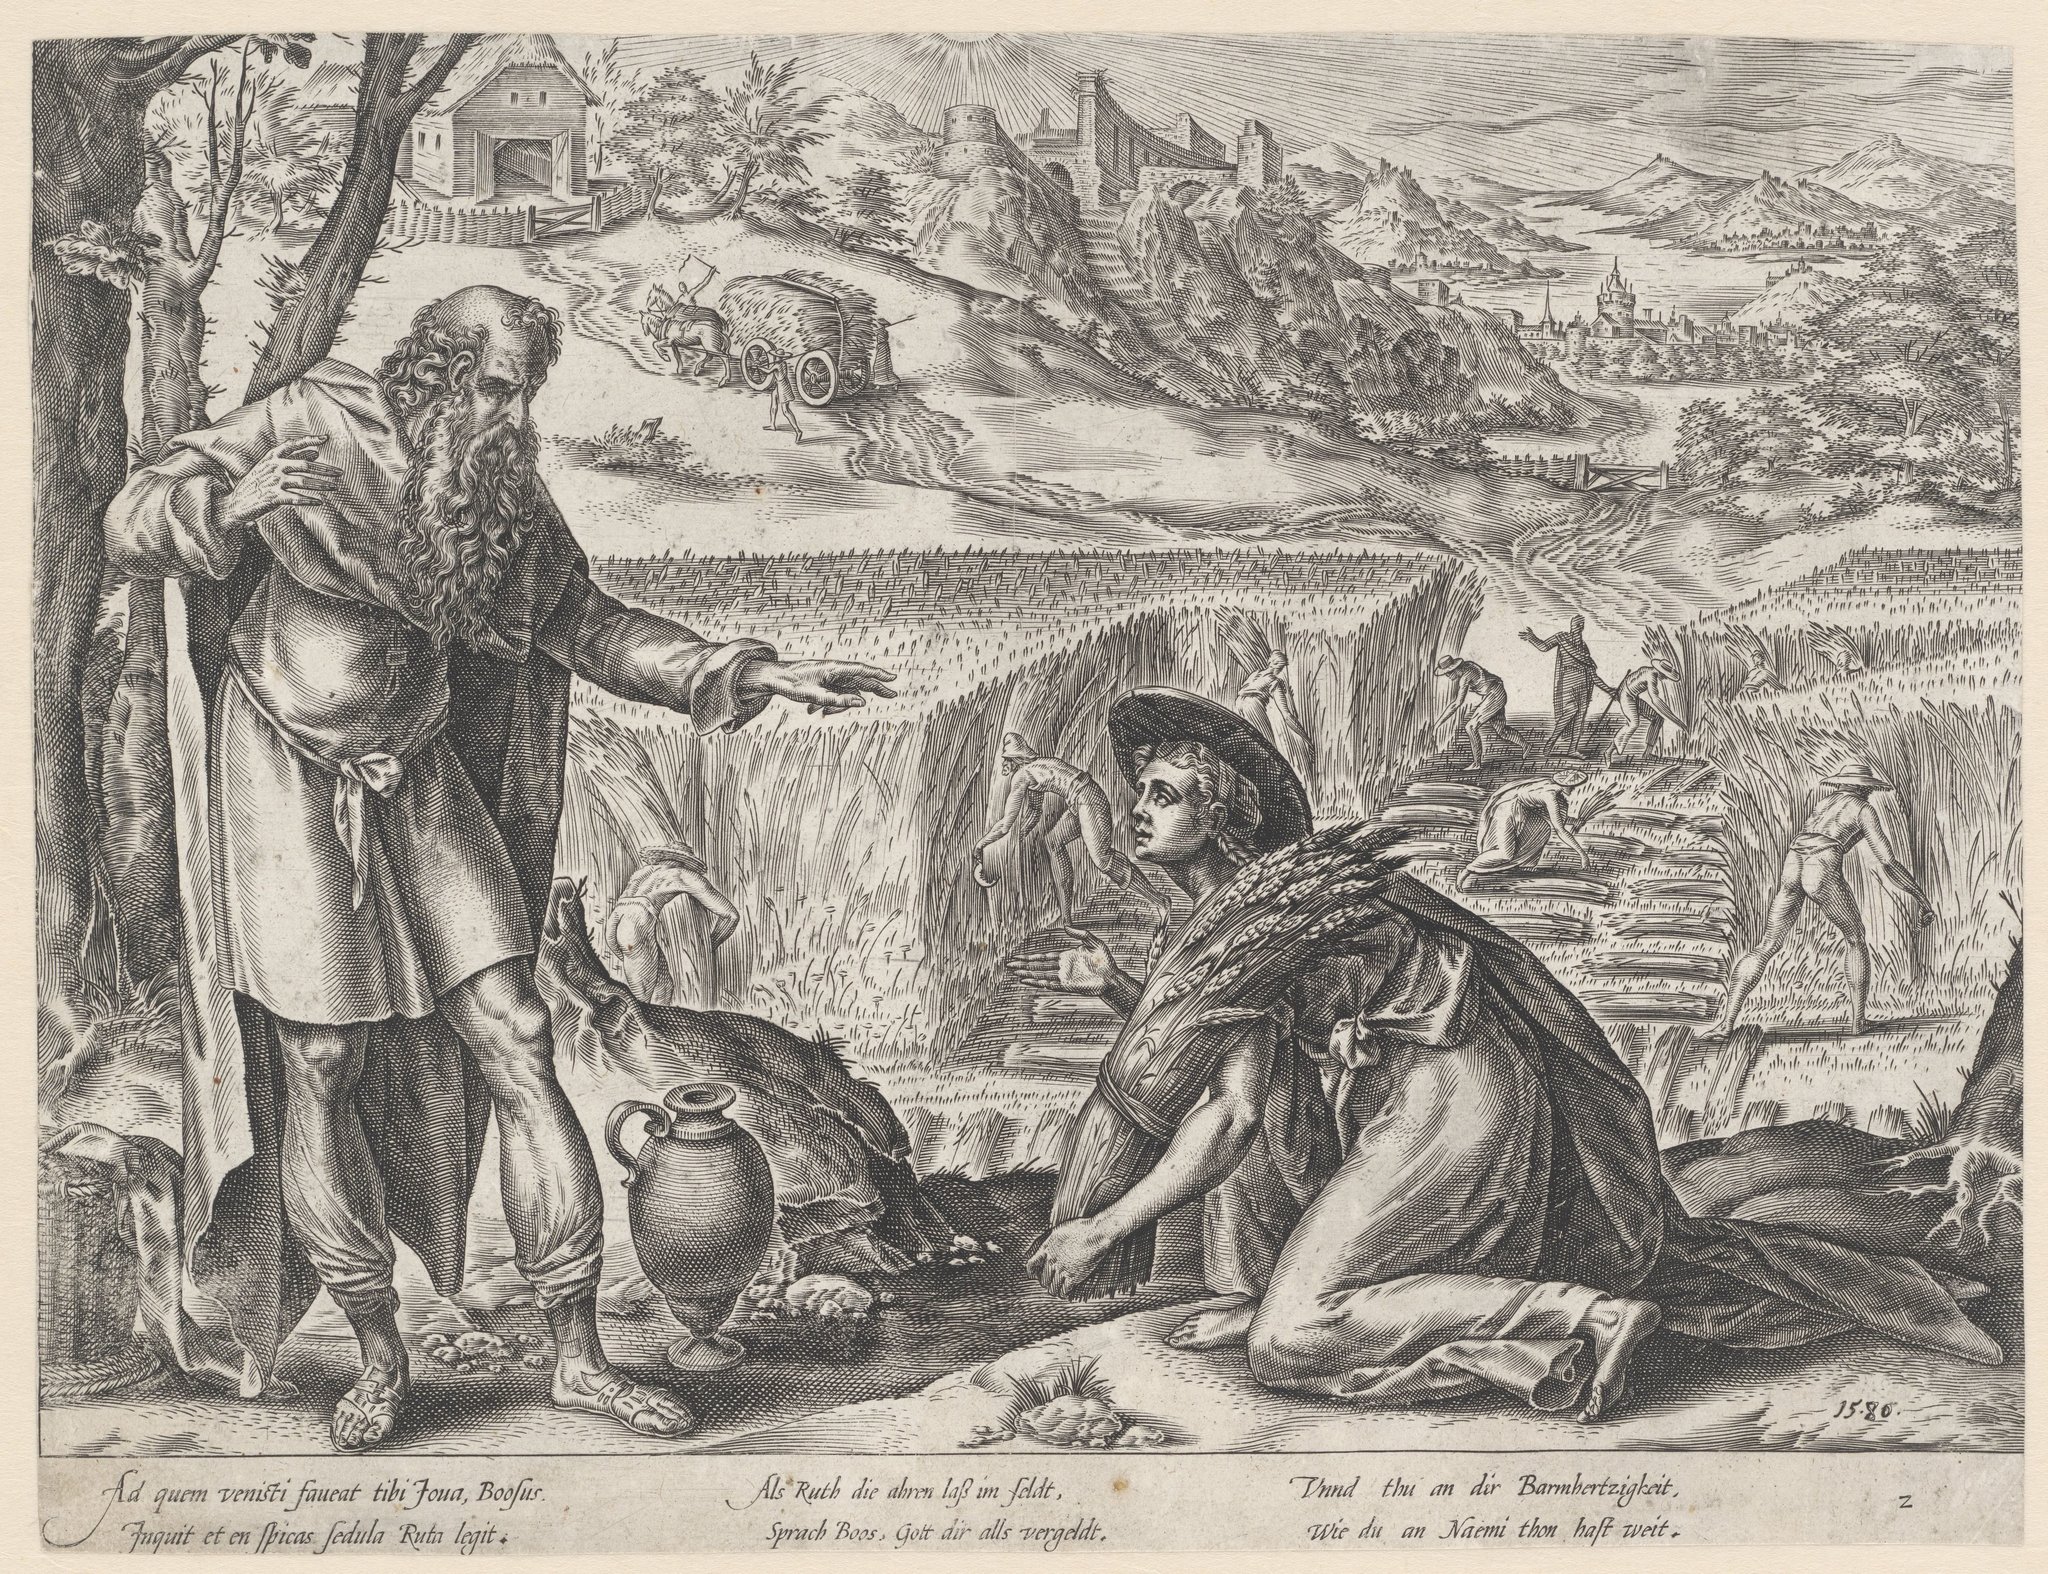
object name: print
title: Ruth leest aren in het veld van Boaz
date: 1580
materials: paper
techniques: engraving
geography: haarlem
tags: ruth in the field of boaz (ruth 2:3-17), boaz speaks to ruth; ruth usually bowing down, or kneeling before him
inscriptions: collector's mark: Lugt 2228, collector's mark: Lugt 2760, date: ‘1580’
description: Ruth en Boaz op de voorgrond. Op de achtergrond worden de aren geoogst. Twee regels Latijn en tweemaal twee regels Duits in marge onder prent.